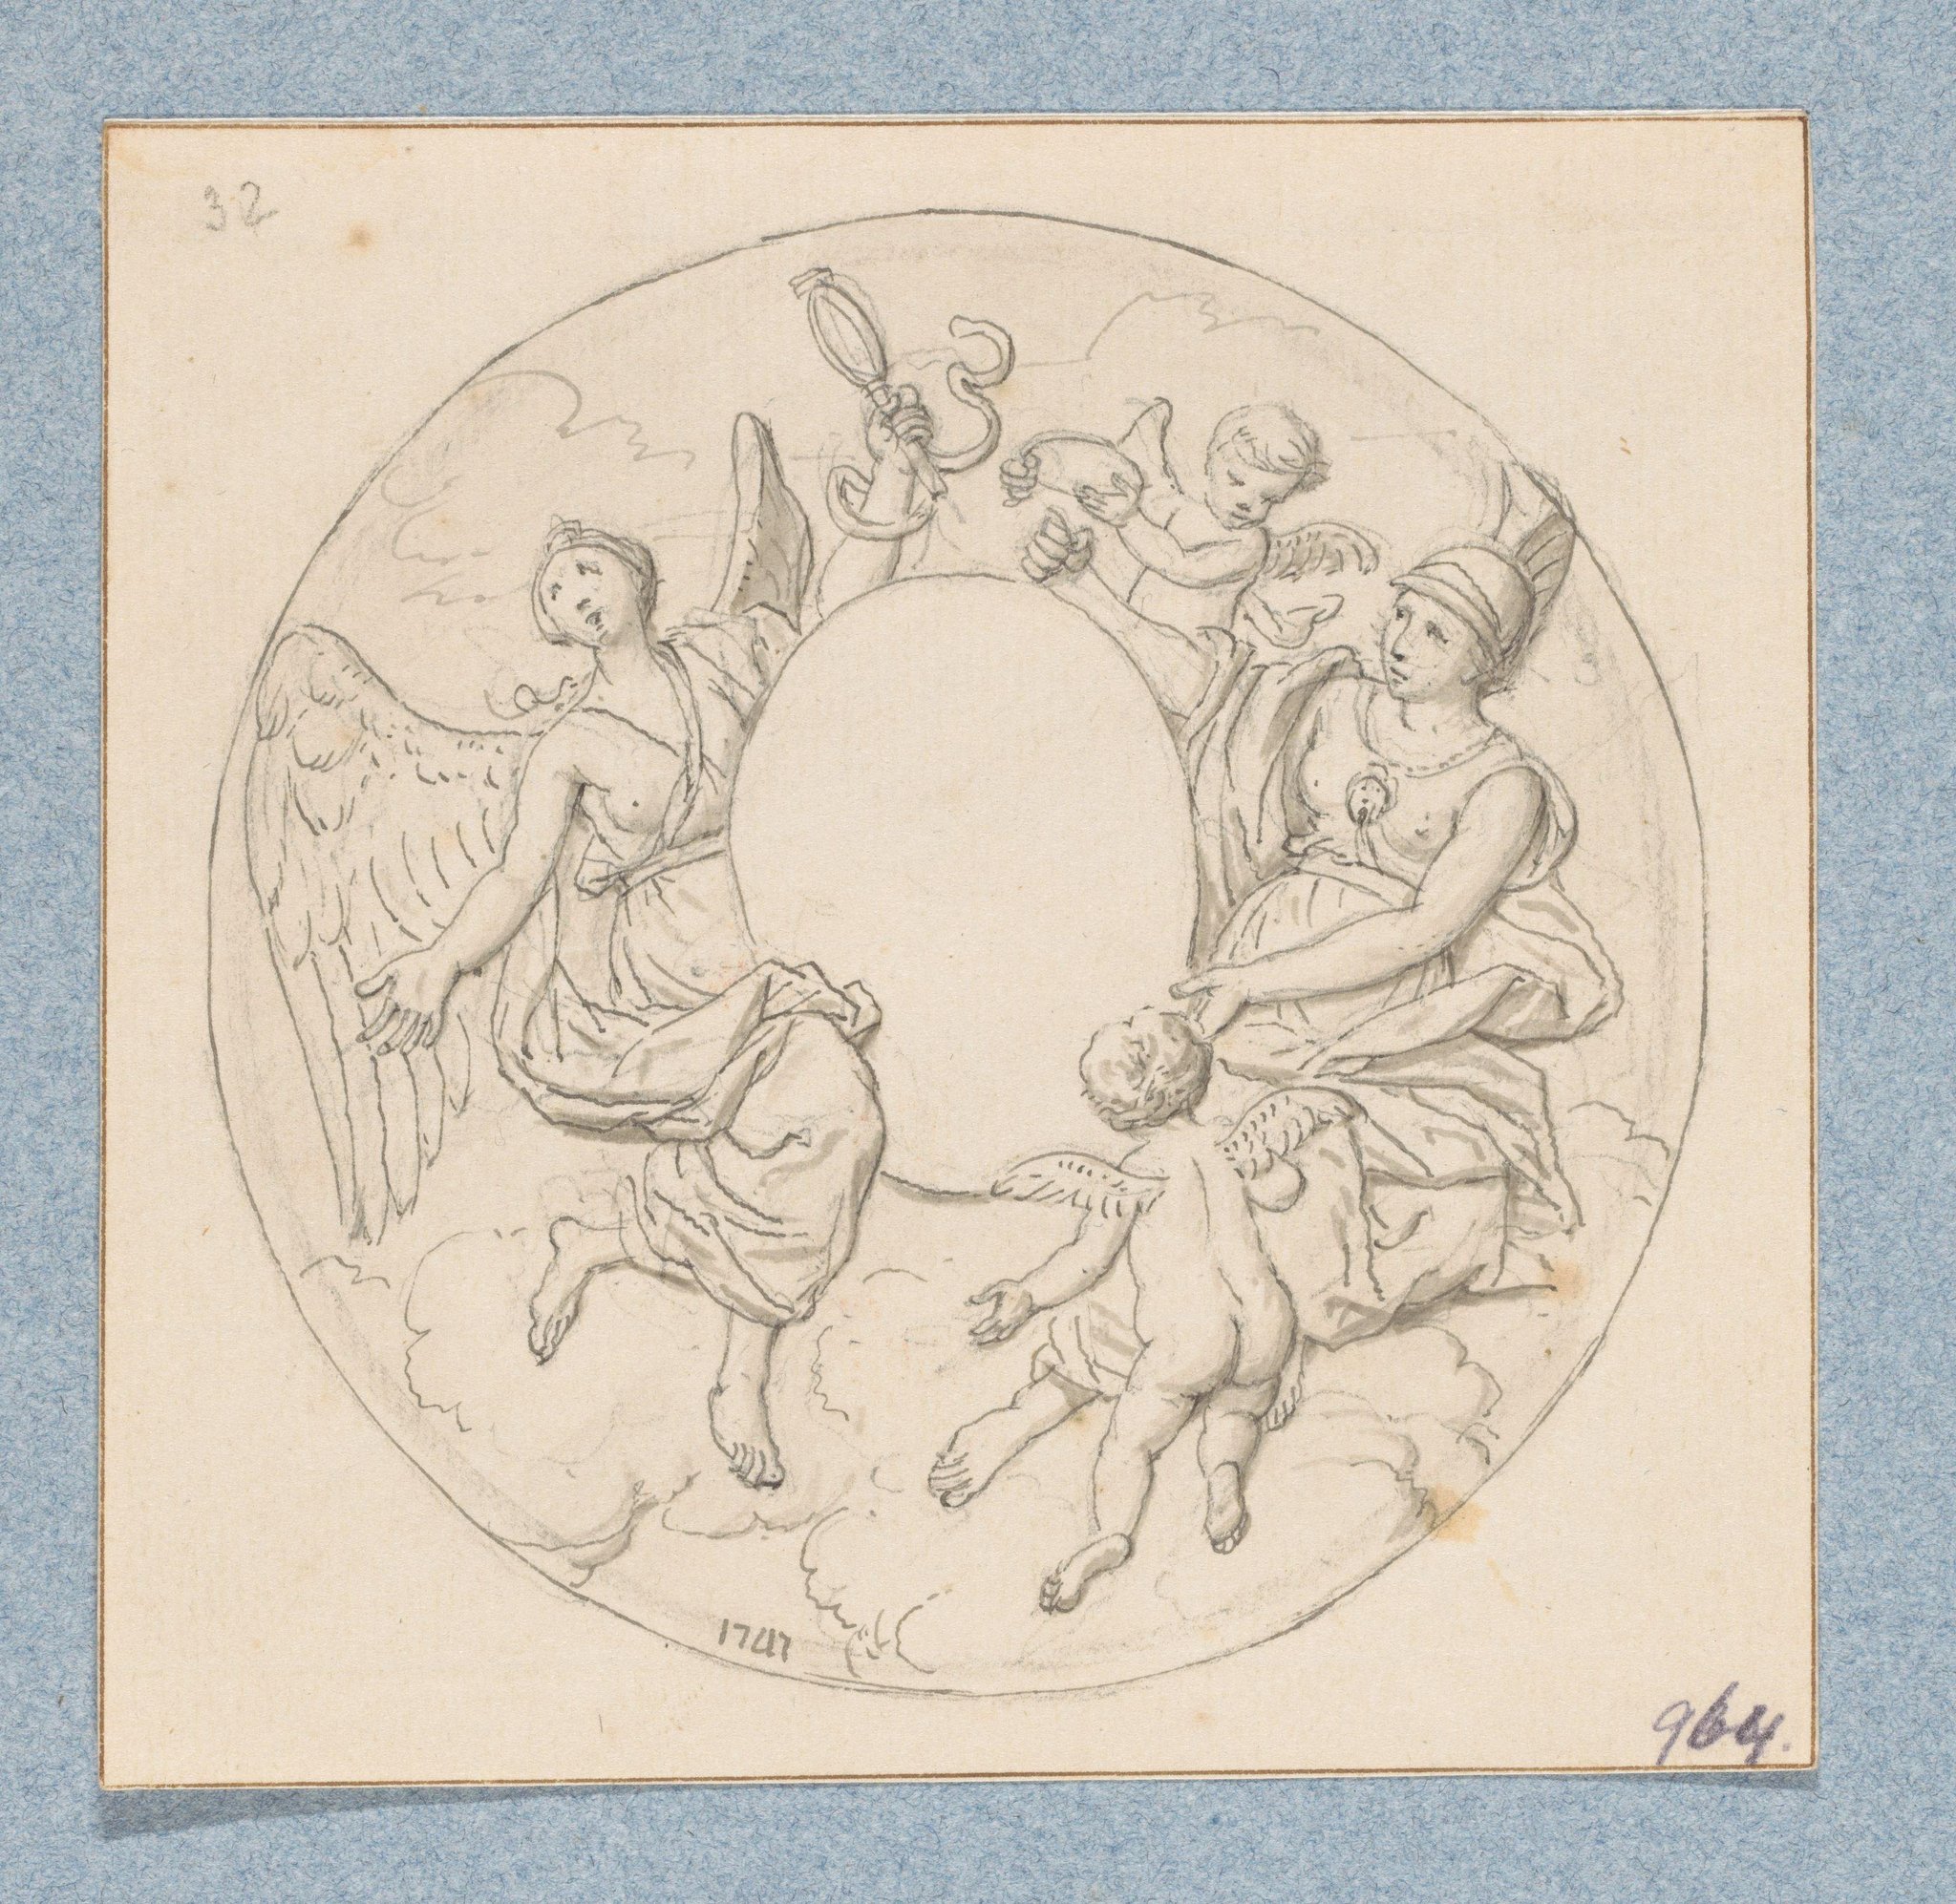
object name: drawing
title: Allegorische cartouche met Prudentia, Minerva en eroten (in doos met 43 tekeningen)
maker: louis fabritius dubourg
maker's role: draughtsman, print maker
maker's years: 1693-1775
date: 1747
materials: ink, paper, pencil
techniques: brush, pen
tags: prudence, 'prudentia'; 'prudenza' (ripa) ~ one of the four cardinal virtues, (story of) minerva (pallas, athena)